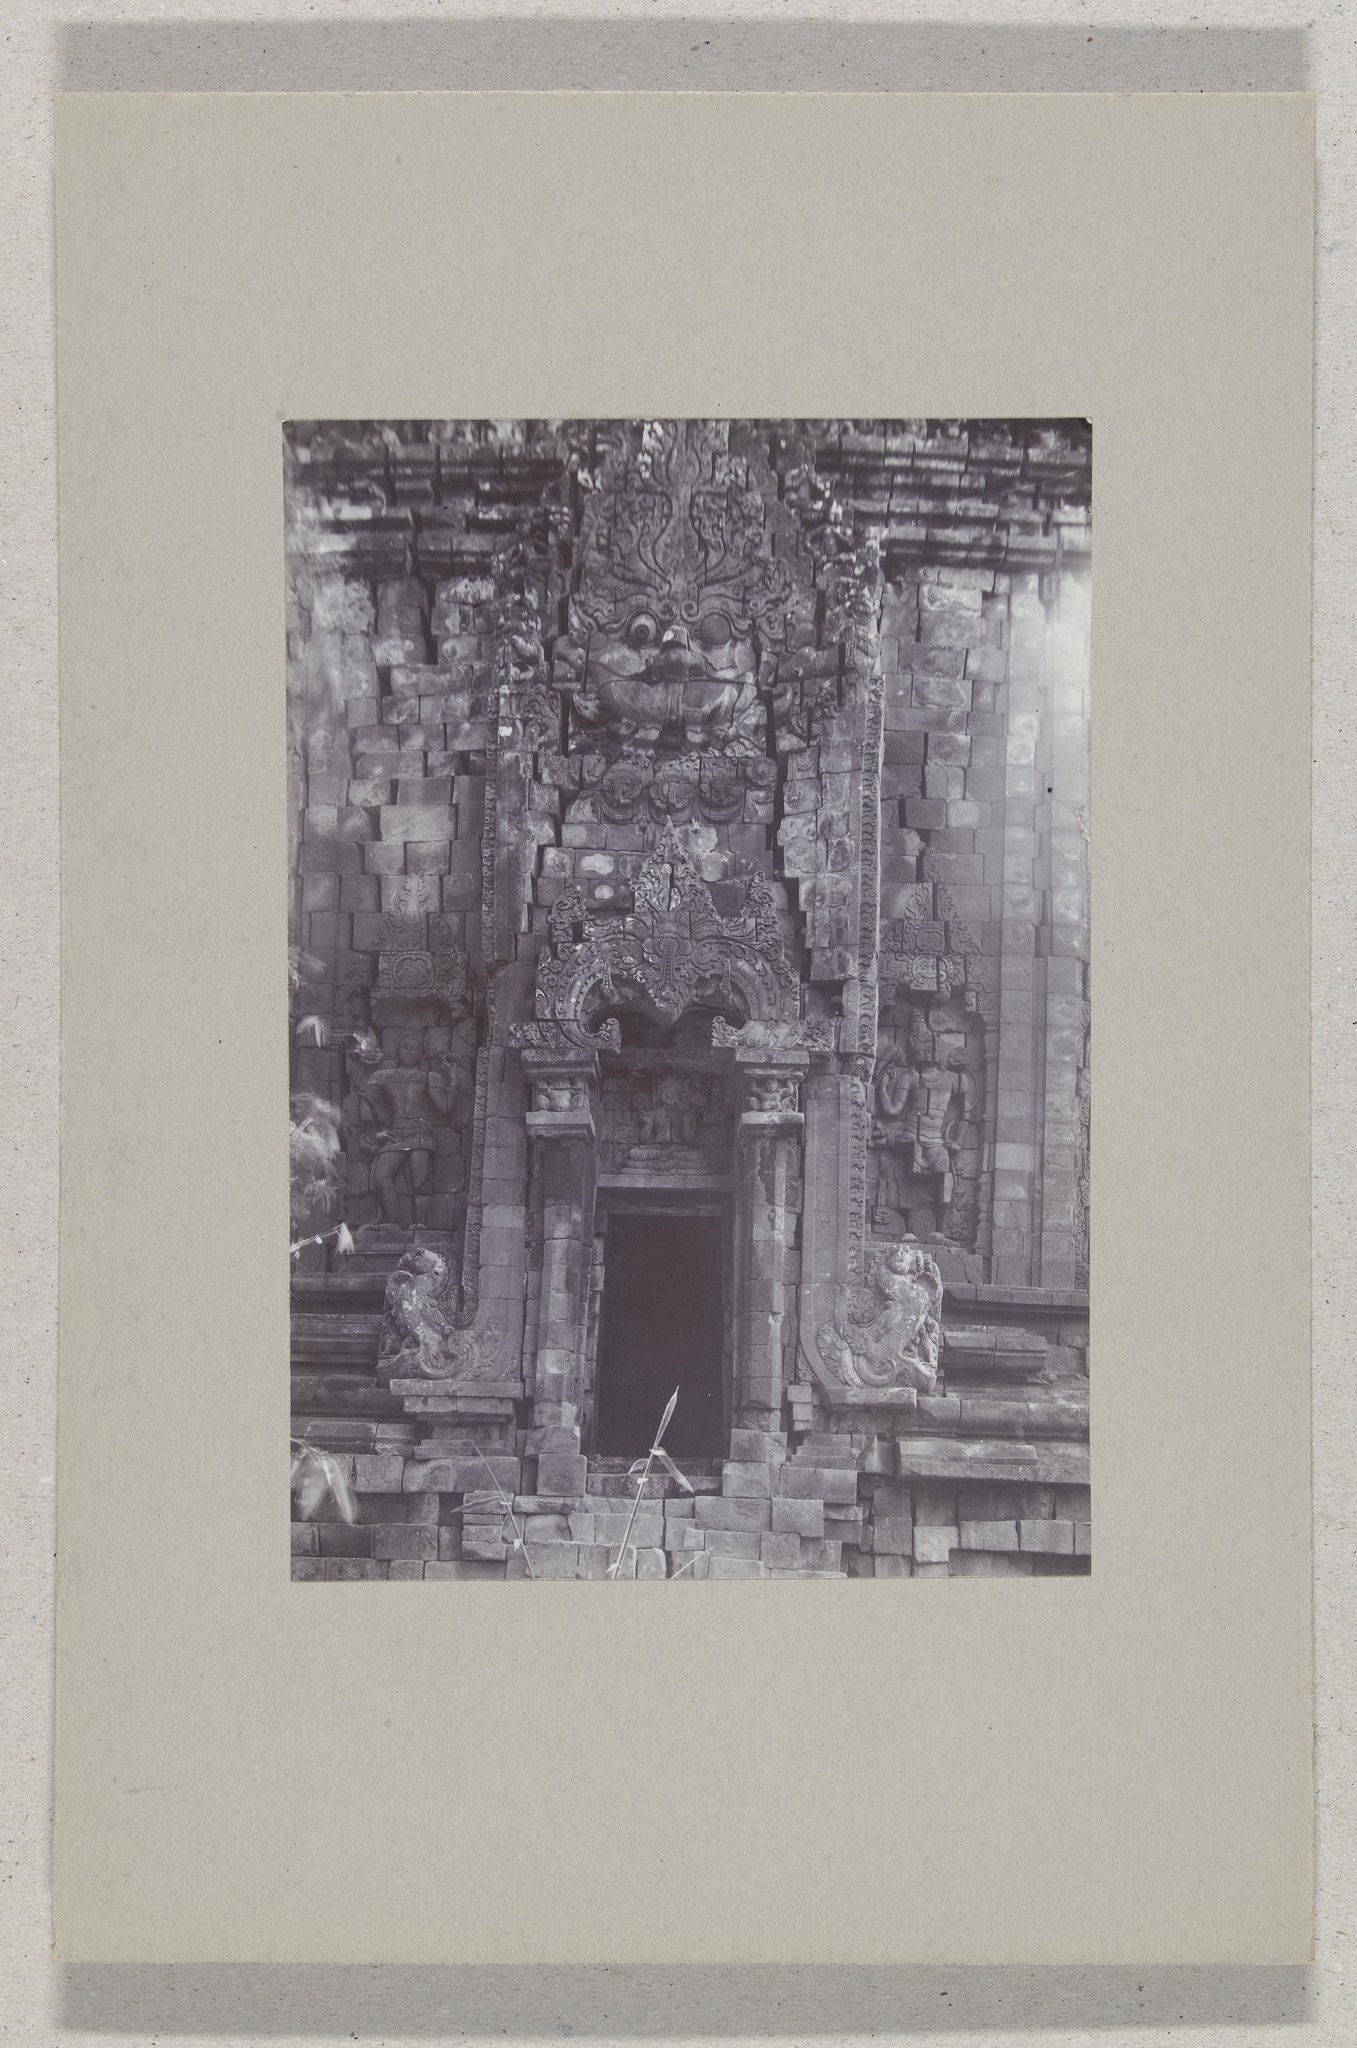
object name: photograph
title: Deurornament van Tjandi Kalasan, nabij Jogyakarta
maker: Anonymous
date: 1895-1915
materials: cardboard, paper, photographic support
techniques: gelatin silver print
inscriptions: number: ‘89a’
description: Deurornament van Tjandi Kalasan, nabij Jogyakarta, Nederlands-Indië